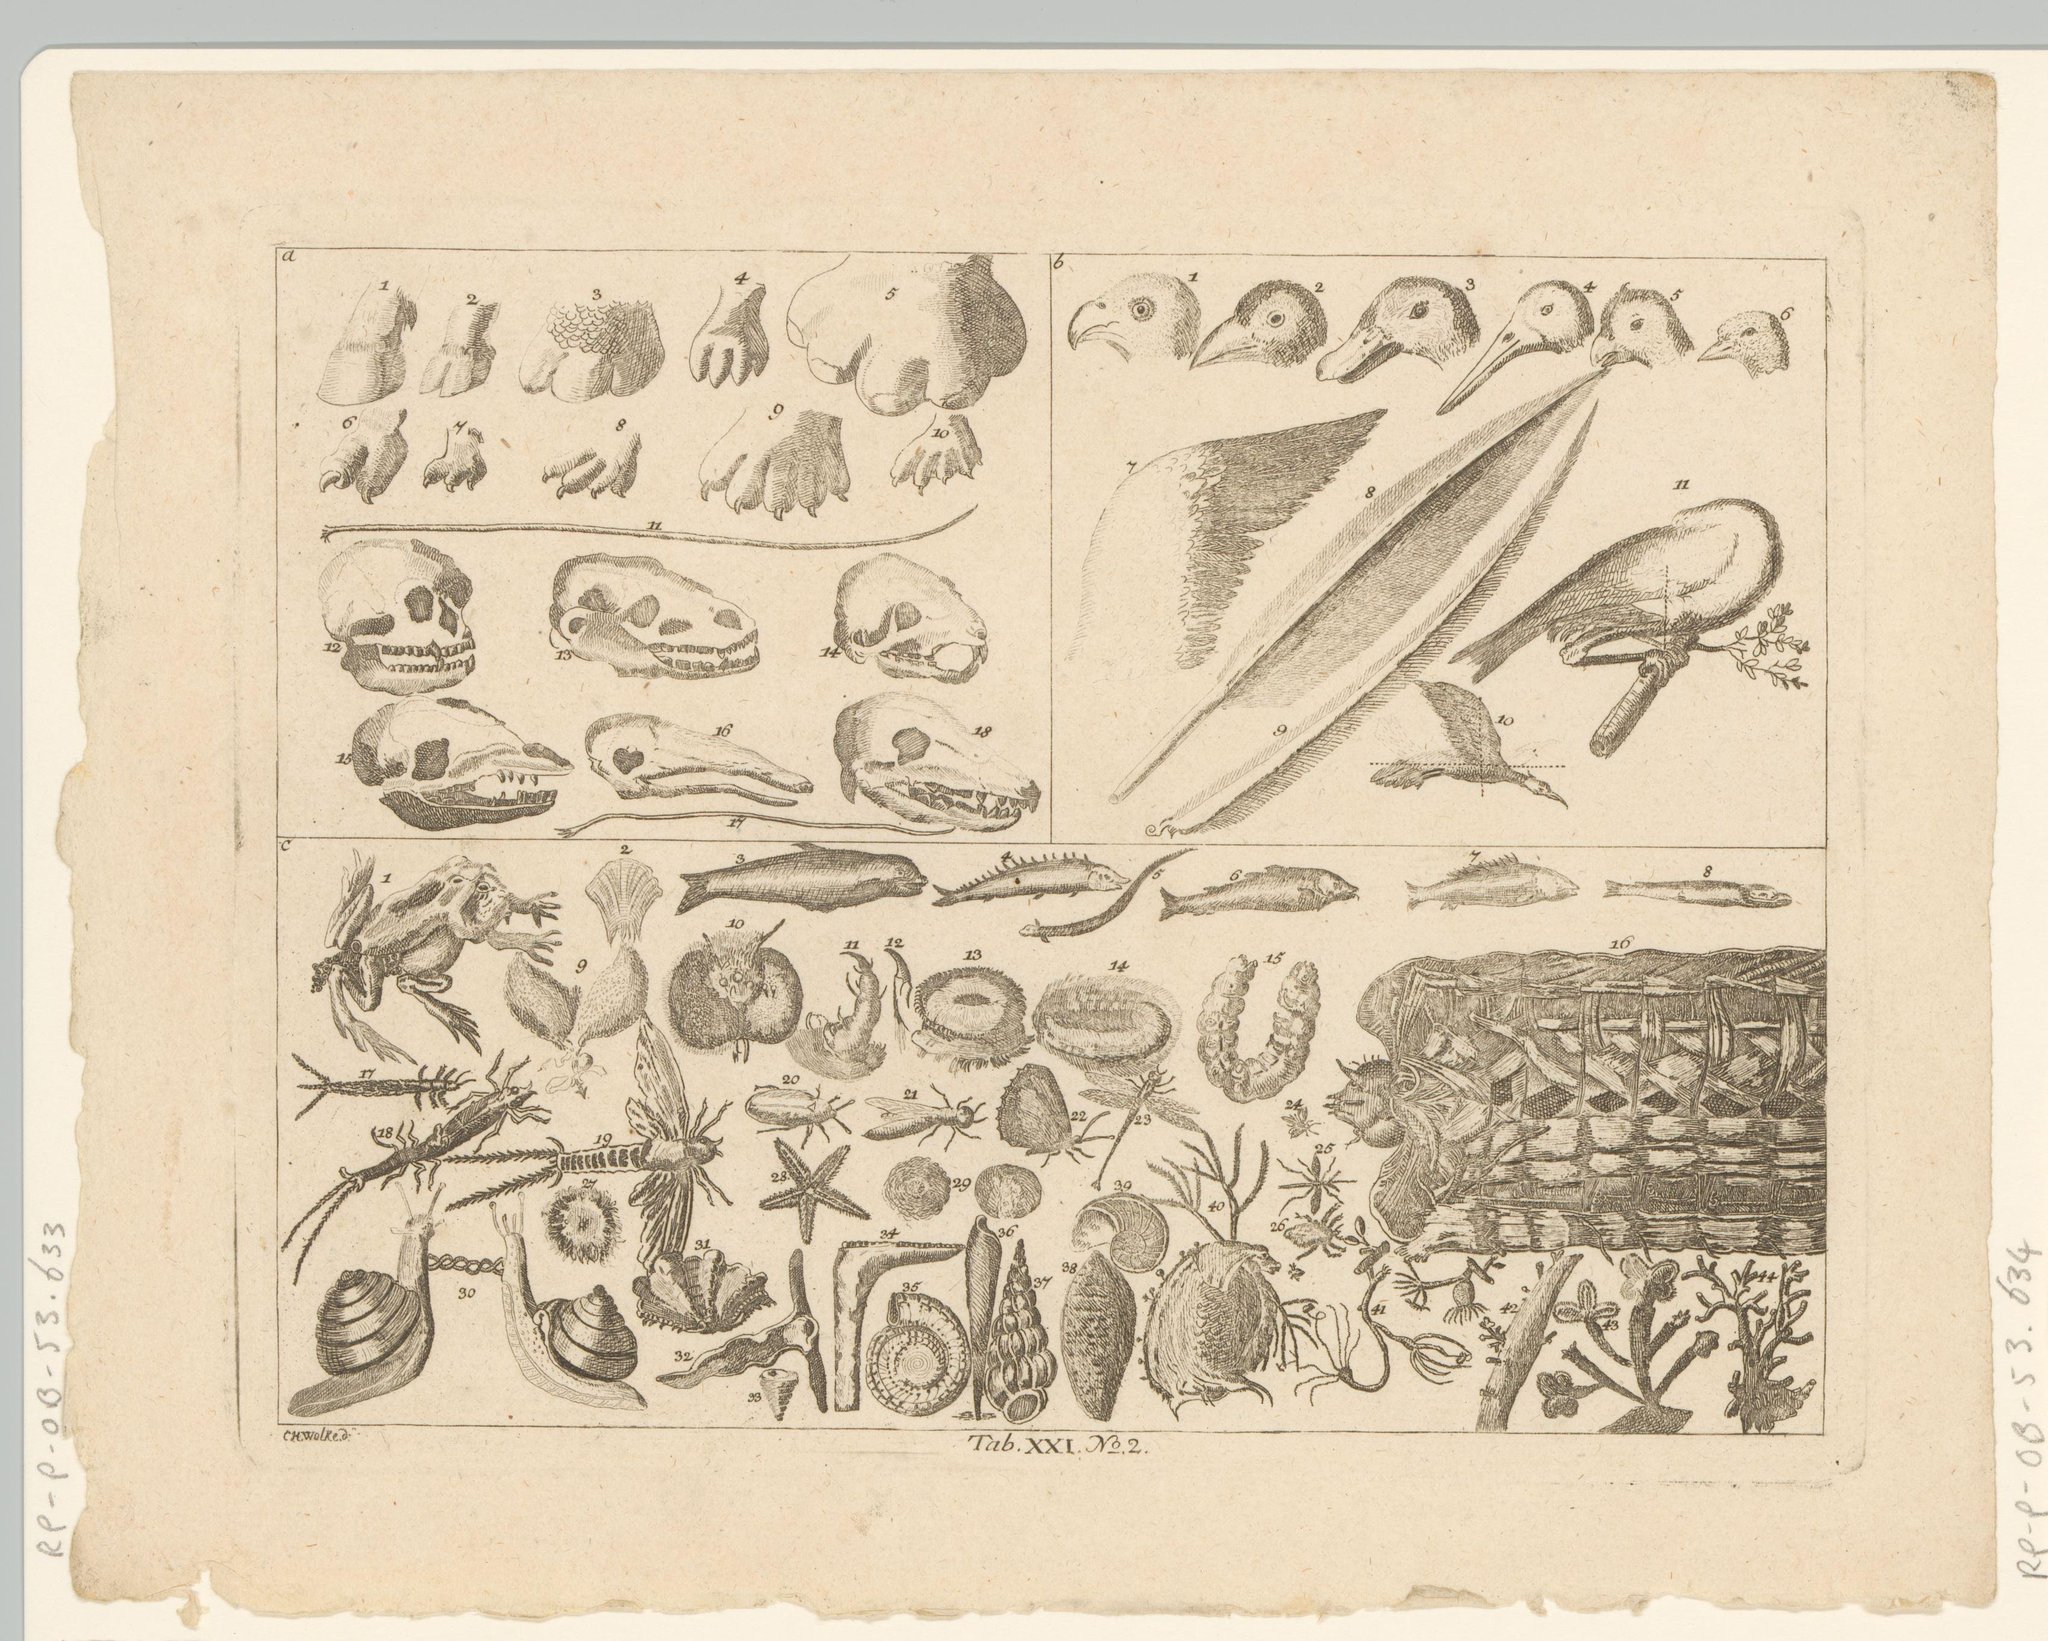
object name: print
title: Encyclopedische voorstelling van dieren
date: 1774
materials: paper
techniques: etching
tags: animals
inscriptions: collector's mark: Lugt 2228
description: Prent afkomstig uit: Kupfersammlung zu J. B. Basedows Elementarwerke für die Jugend und ihre Freunde. Berlijn: Daniel Chodowiecki, 1774.